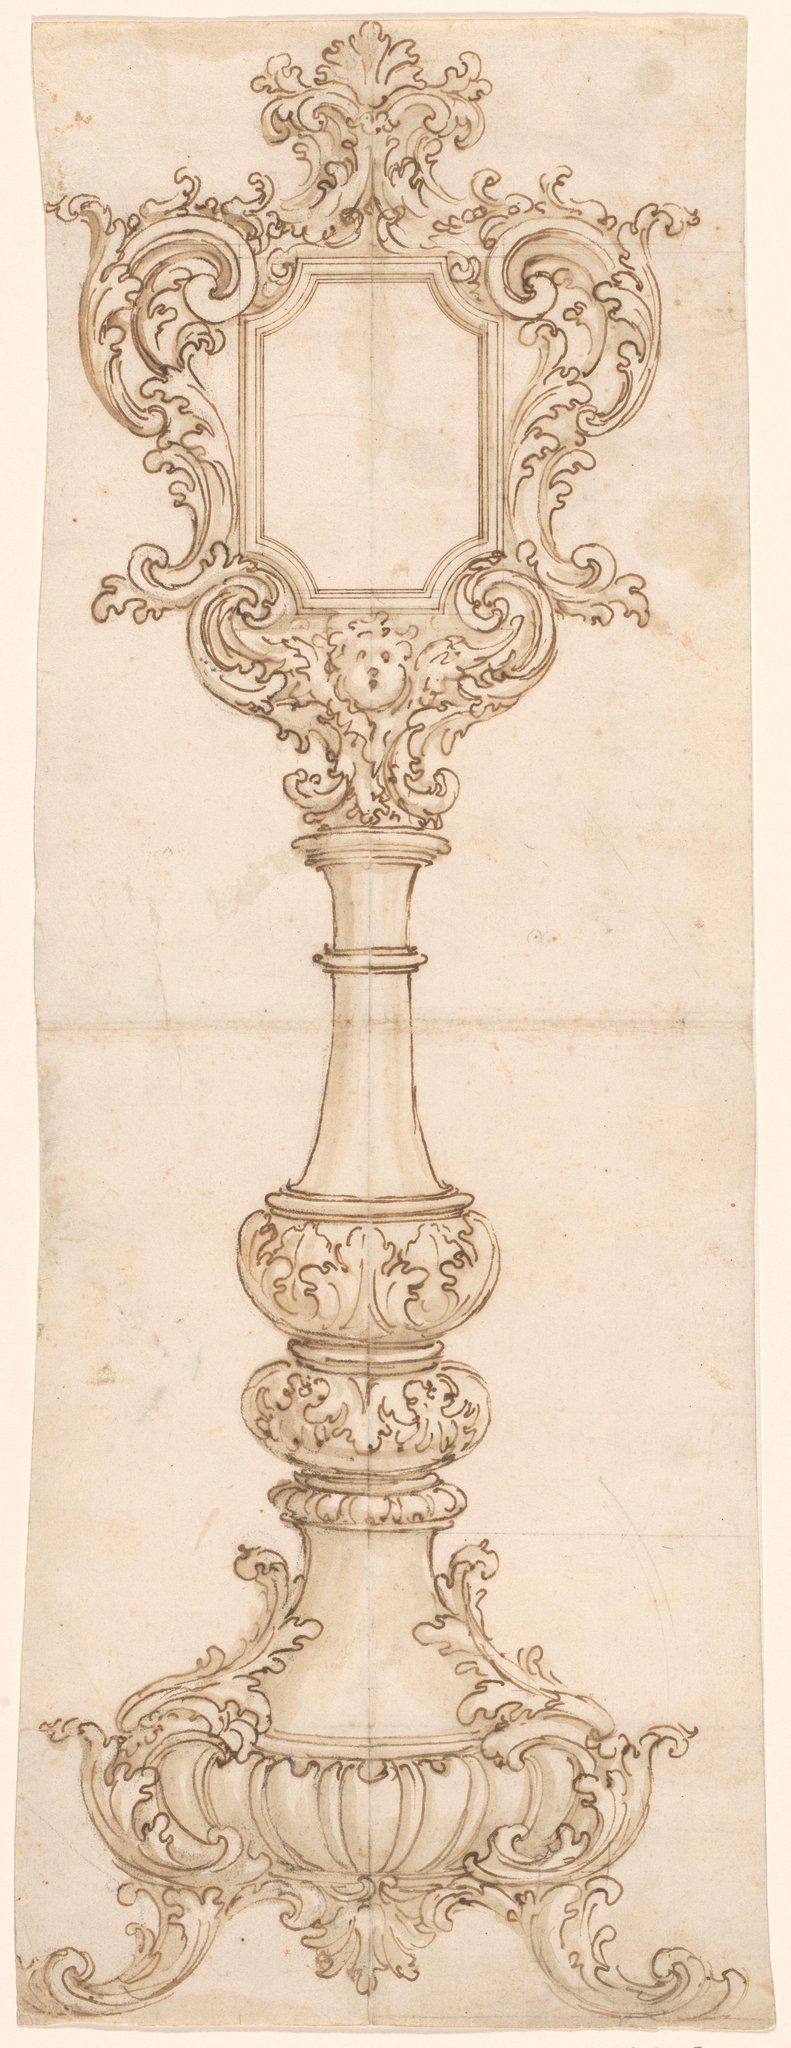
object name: design drawing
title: Ontwerp voor een reliekhouder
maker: giovanni battista foggini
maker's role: draughtsman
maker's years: 1652-1725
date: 1700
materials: graphite, ink, paper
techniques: brush, pen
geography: florence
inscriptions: watermark